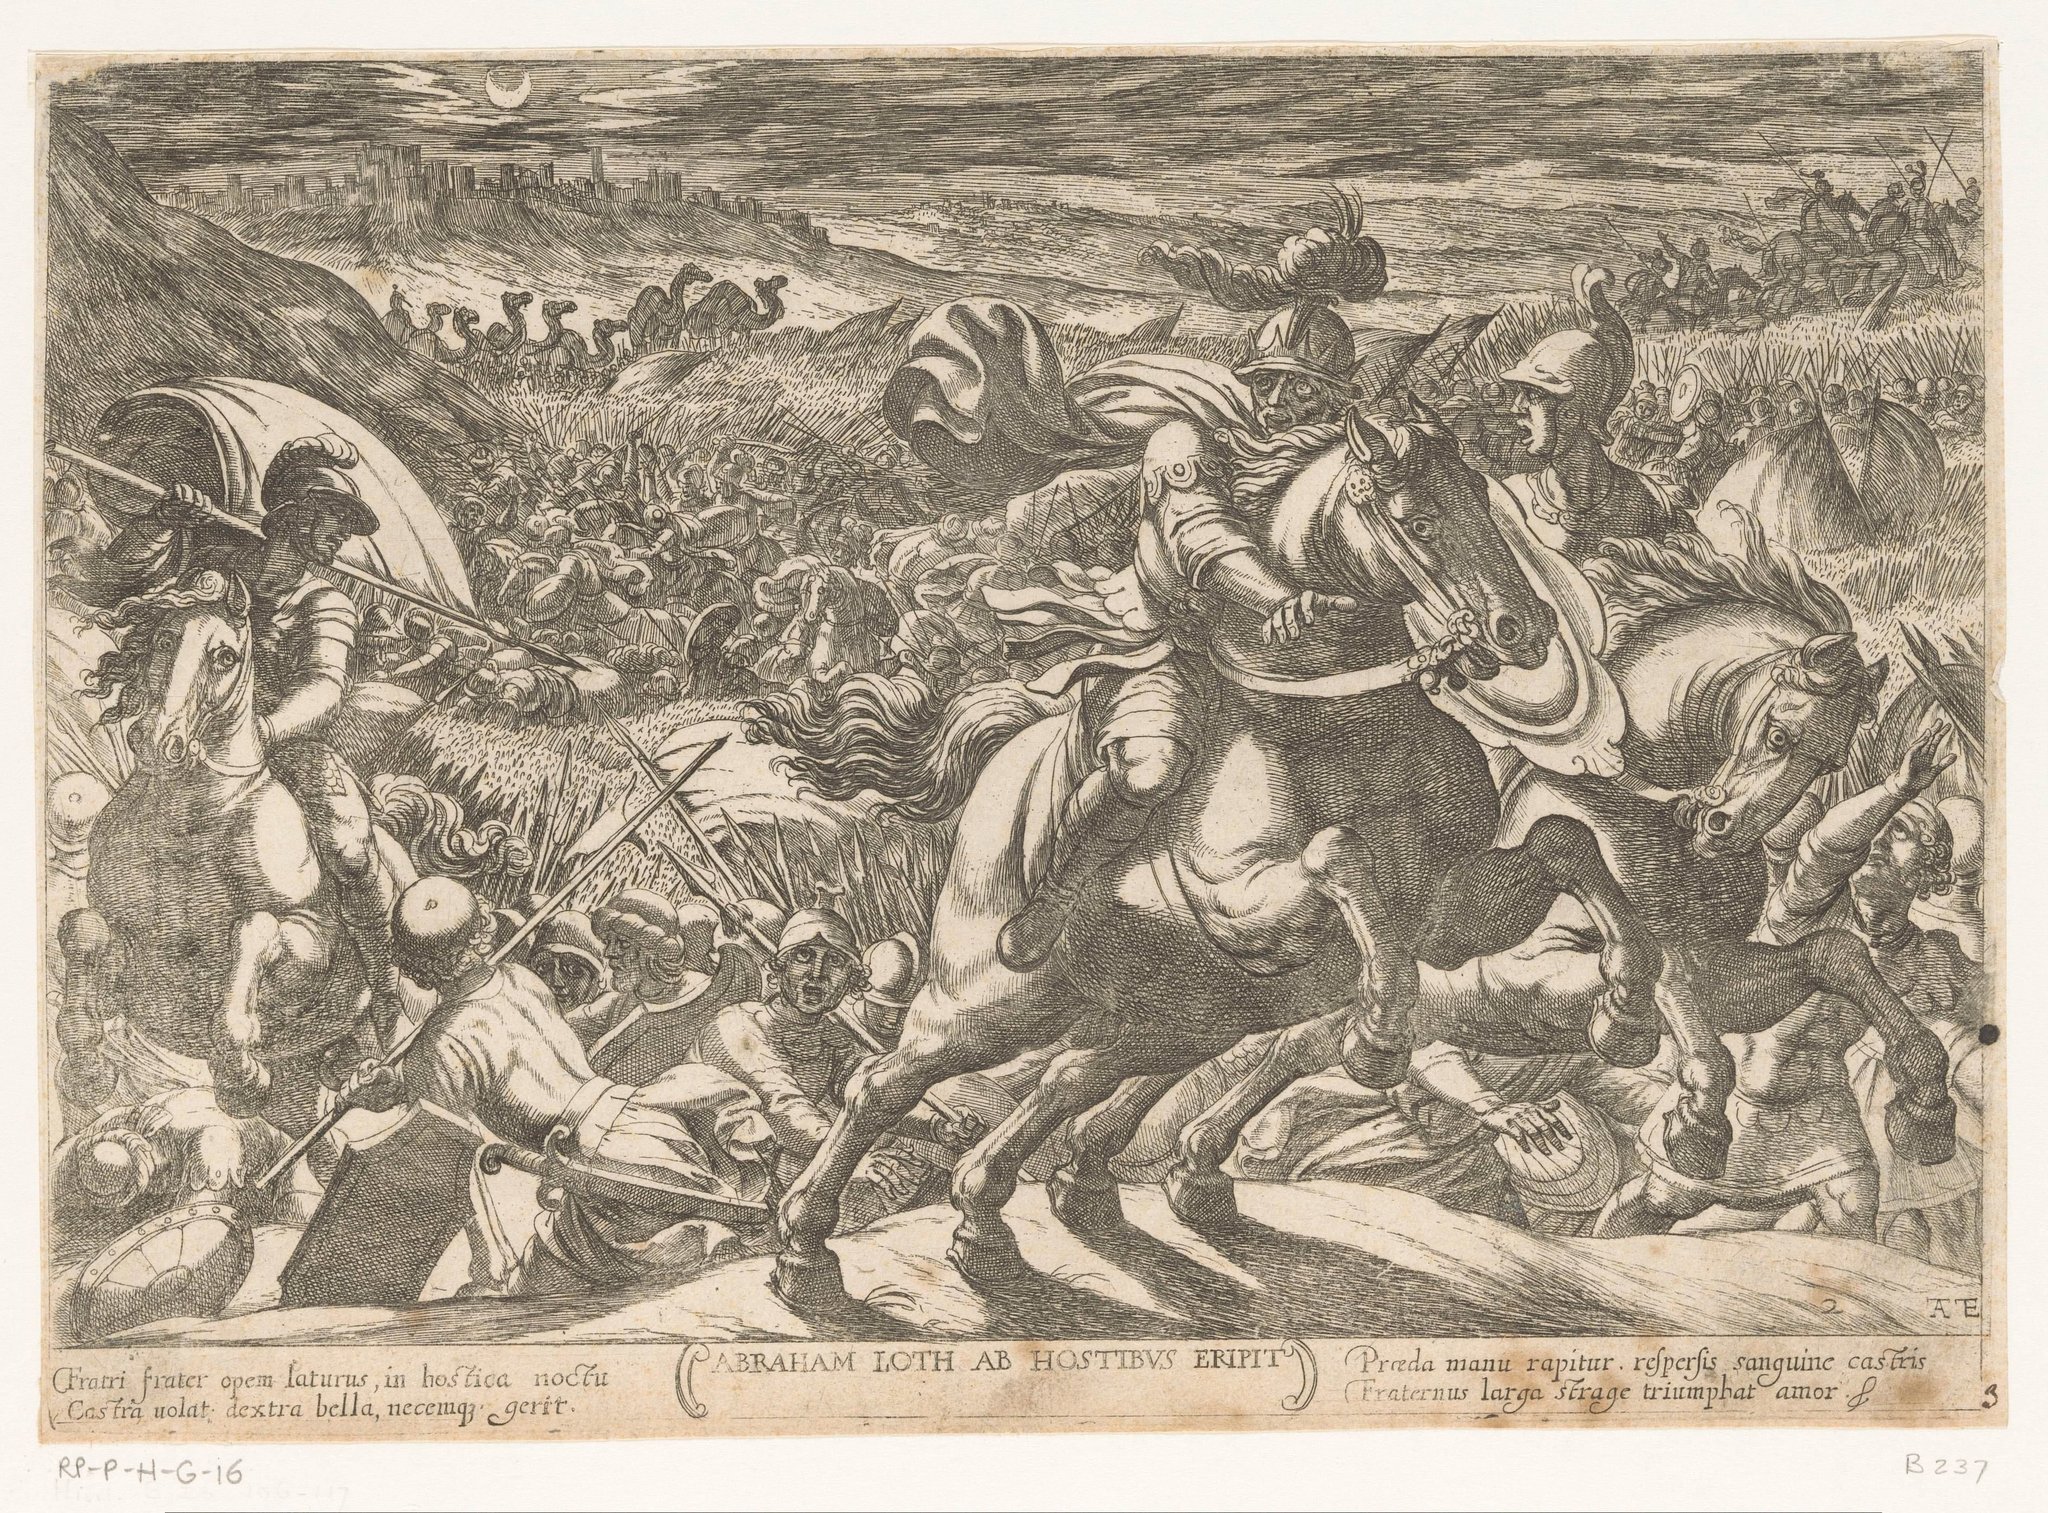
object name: print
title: Oudtestamentische strijdscènes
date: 1613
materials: paper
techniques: etching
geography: italy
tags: abraham liberates lot, recovers the stolen goods and returns in triumph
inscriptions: number: ‘3’, collector's mark: ‘Hinloopen’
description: Abraham en zijn leger (van 318 personen die in zijn huis opgegroeid waren) in strijd met Kedorlaomer en diens bondgenoten om Lot te bevrijden. Titel en onderschrift in het Latijn in de ondermarge.